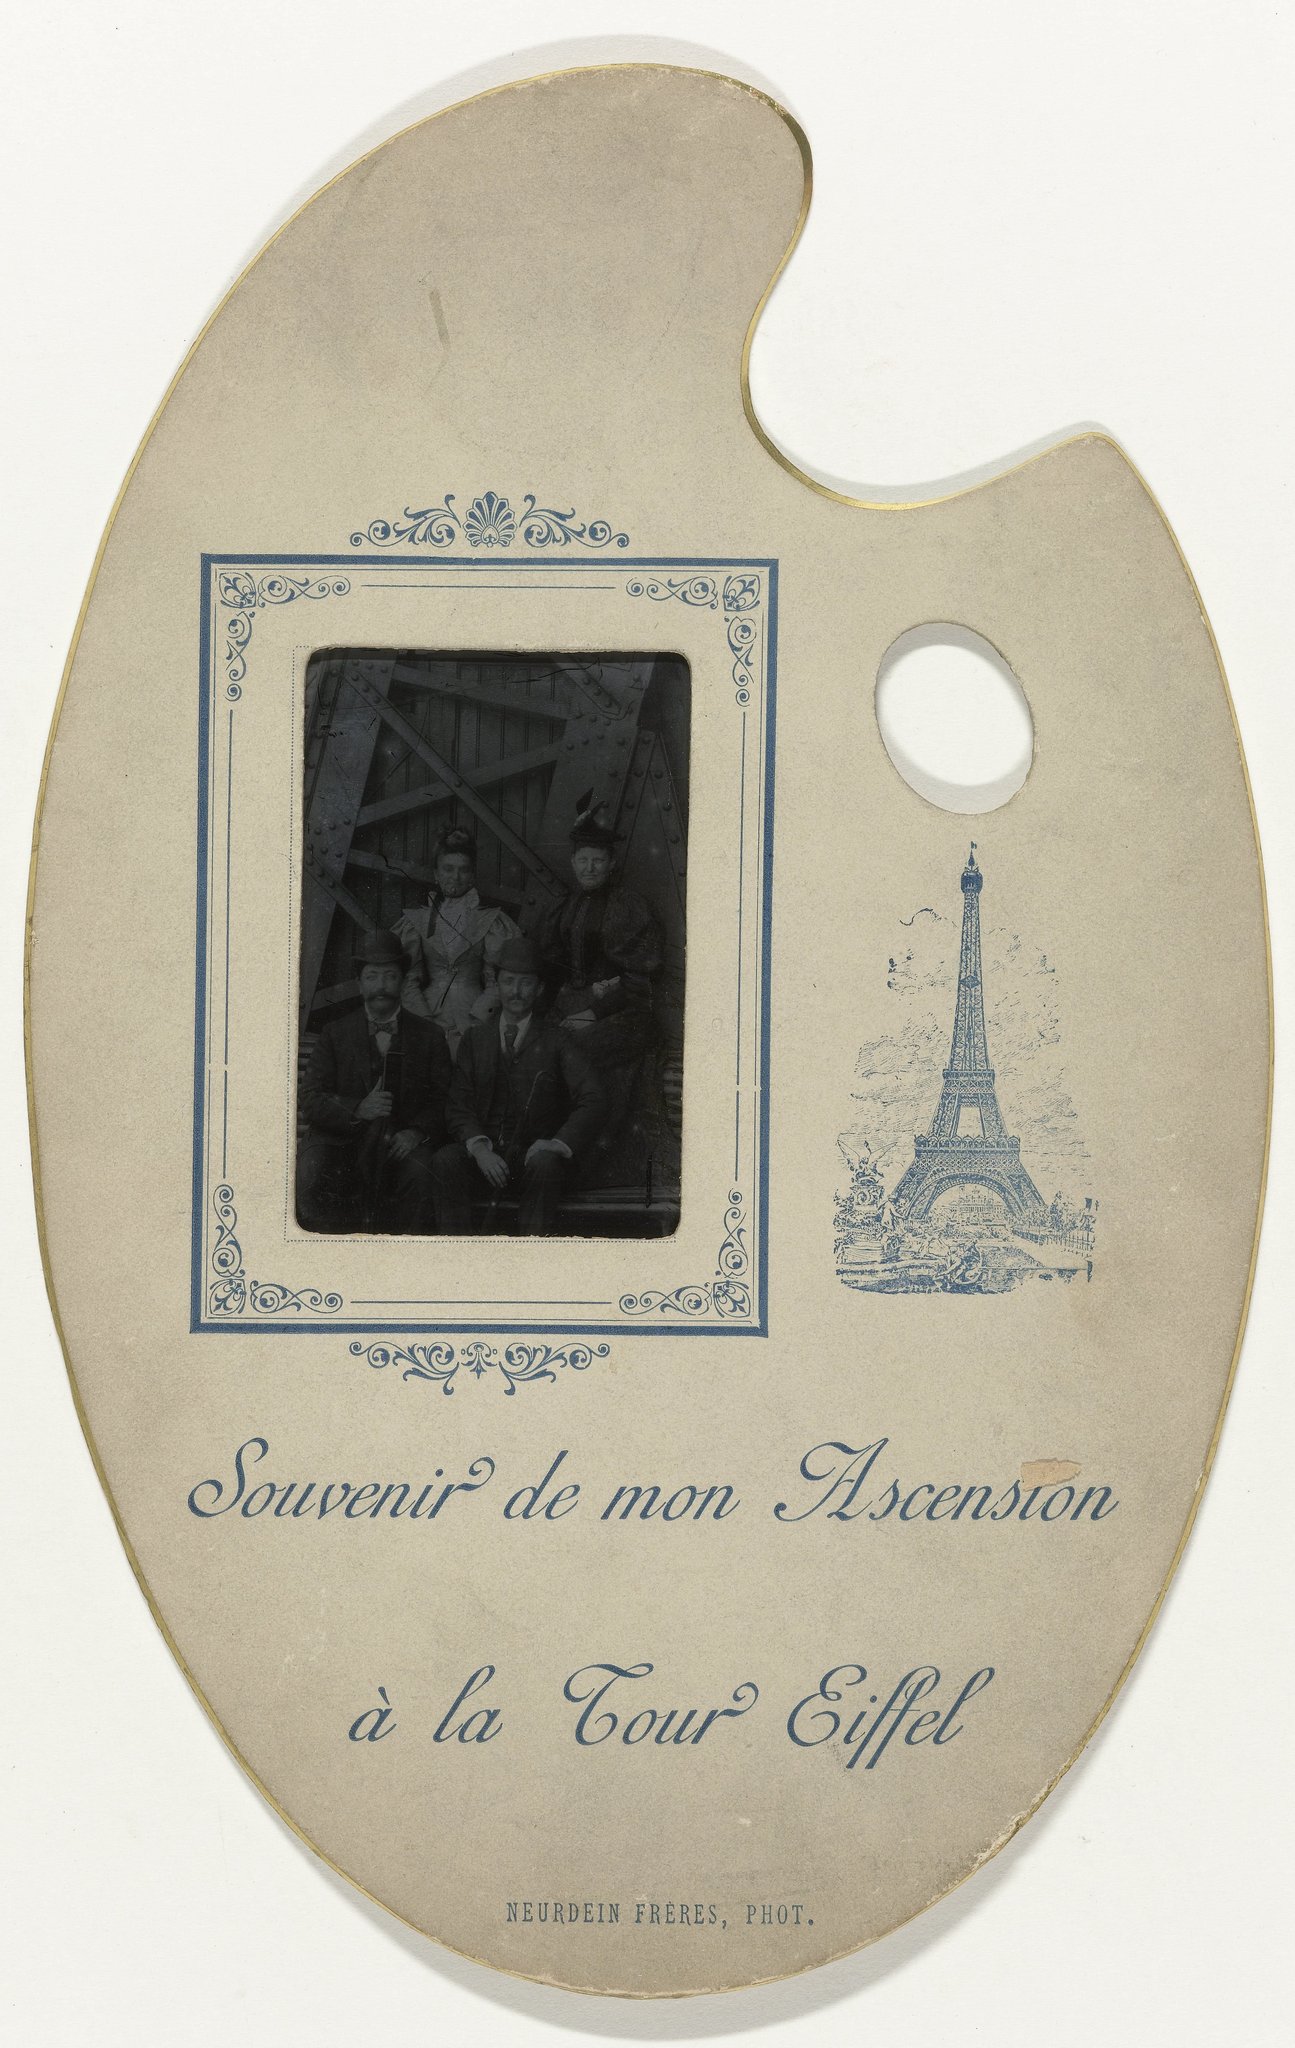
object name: photograph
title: Twee mannen en twee vrouwen op de Eiffeltoren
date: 1889-1914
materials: cardboard, metal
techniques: ferrotyping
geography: paris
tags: palette, eiffel tower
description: Twee mannen en twee vrouwen op de Eiffeltoren. In een kartonnen passepartout in de vorm van een schilderspalet